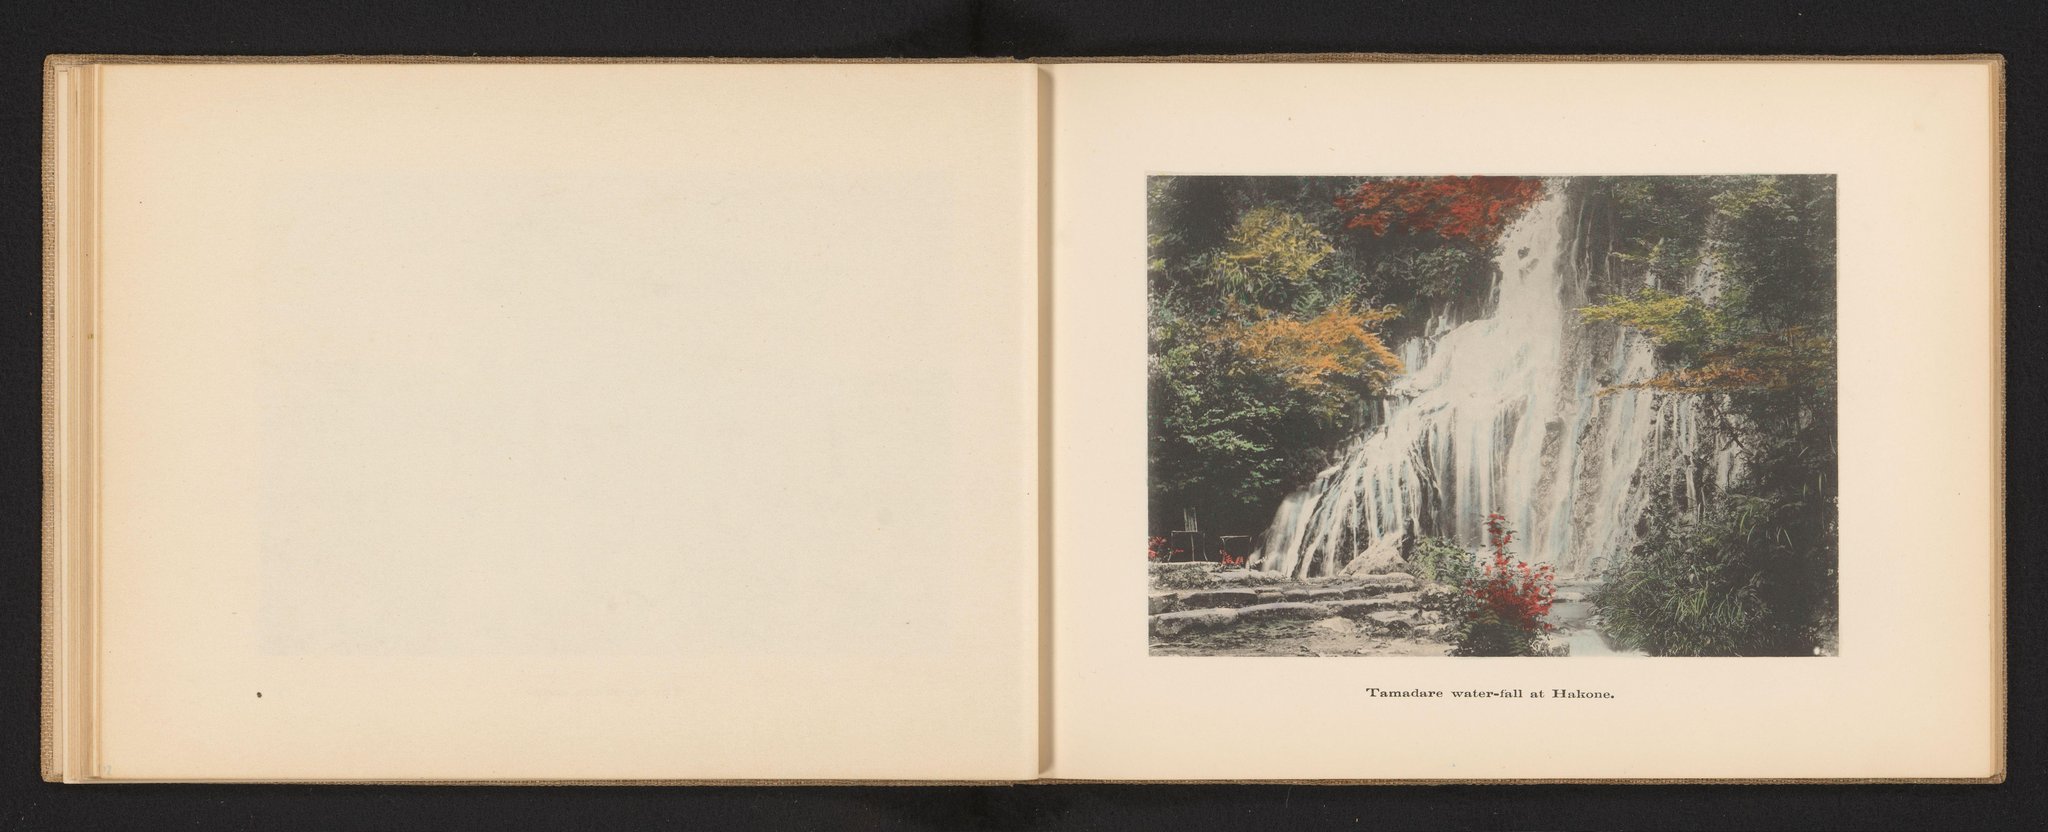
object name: photomechanical print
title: Tamadare water-fall at Hakone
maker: kōzaburō tamamura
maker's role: fotograaf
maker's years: 1856-1923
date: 1895-1905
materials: paper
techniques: photograph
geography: hakone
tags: waterfall